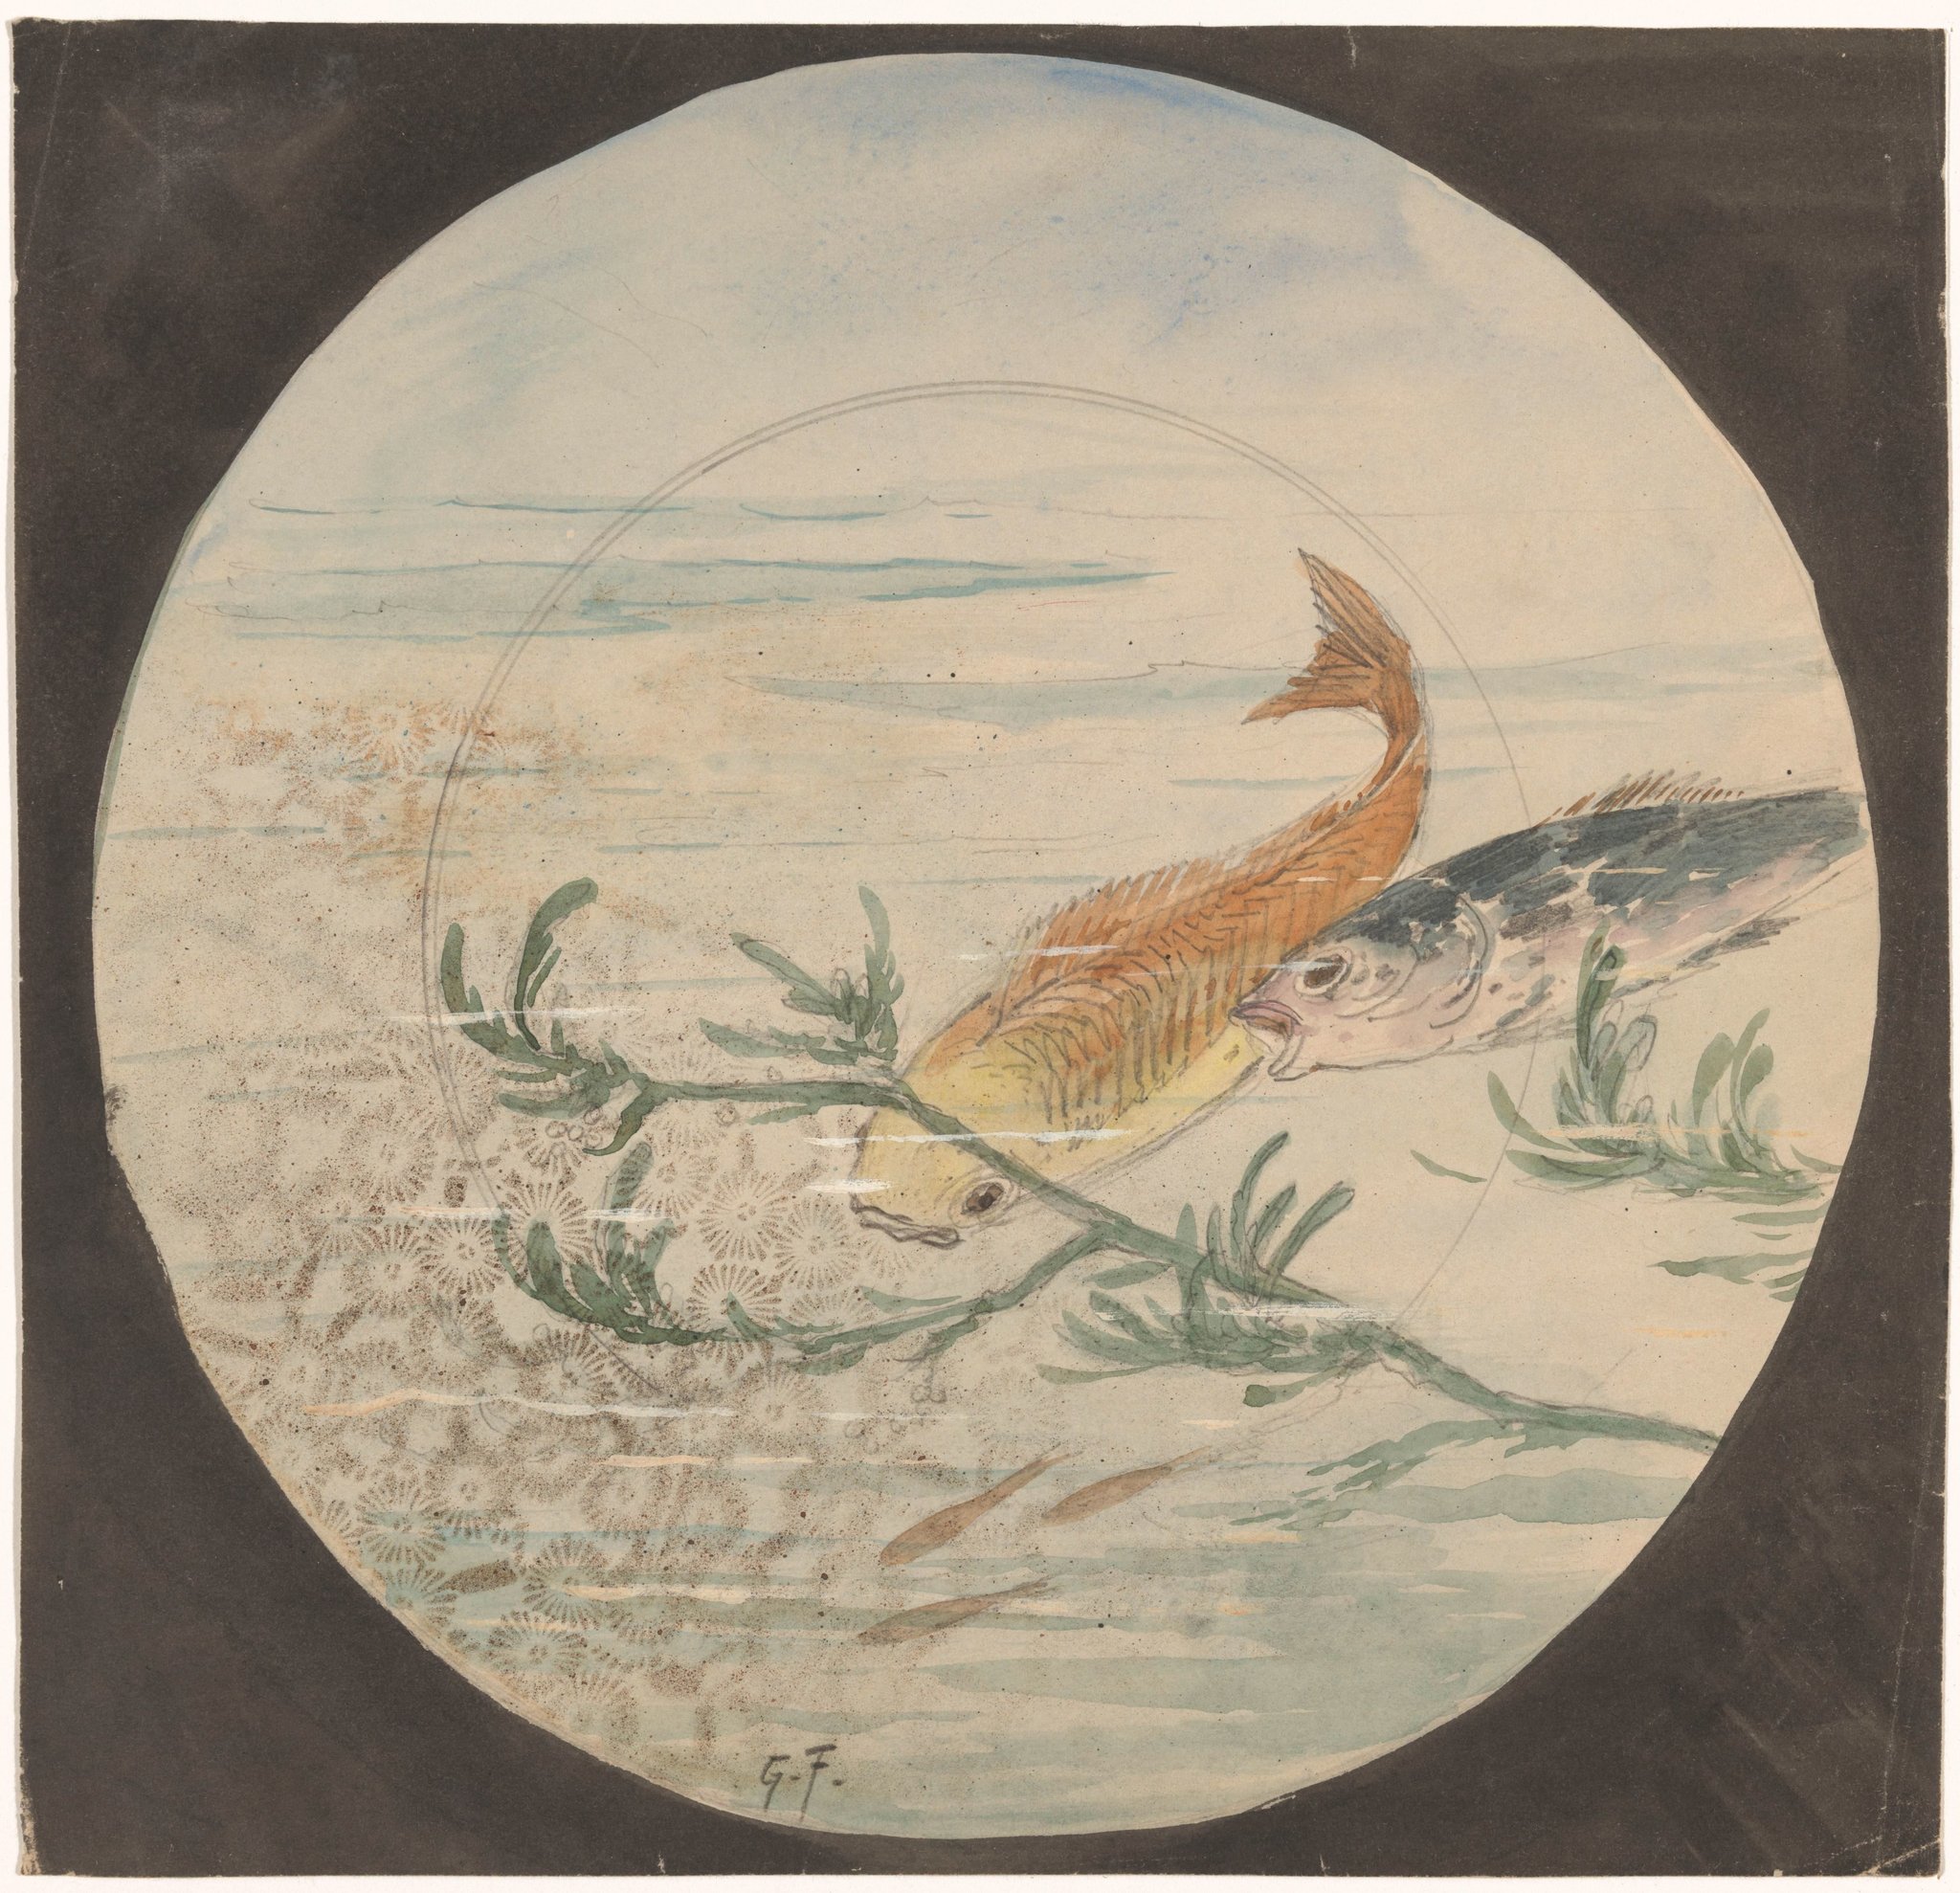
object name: design drawing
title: Ontwerp voor een bord met een gele en een blauwe, omlaagzwemmende vis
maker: gustave fraipont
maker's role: painter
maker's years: 1849-1923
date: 1875-1890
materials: graphite, paper, watercolor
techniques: aquarelle, brush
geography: paris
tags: fishes, dish, plate, saucer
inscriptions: signature: ‘G.F’